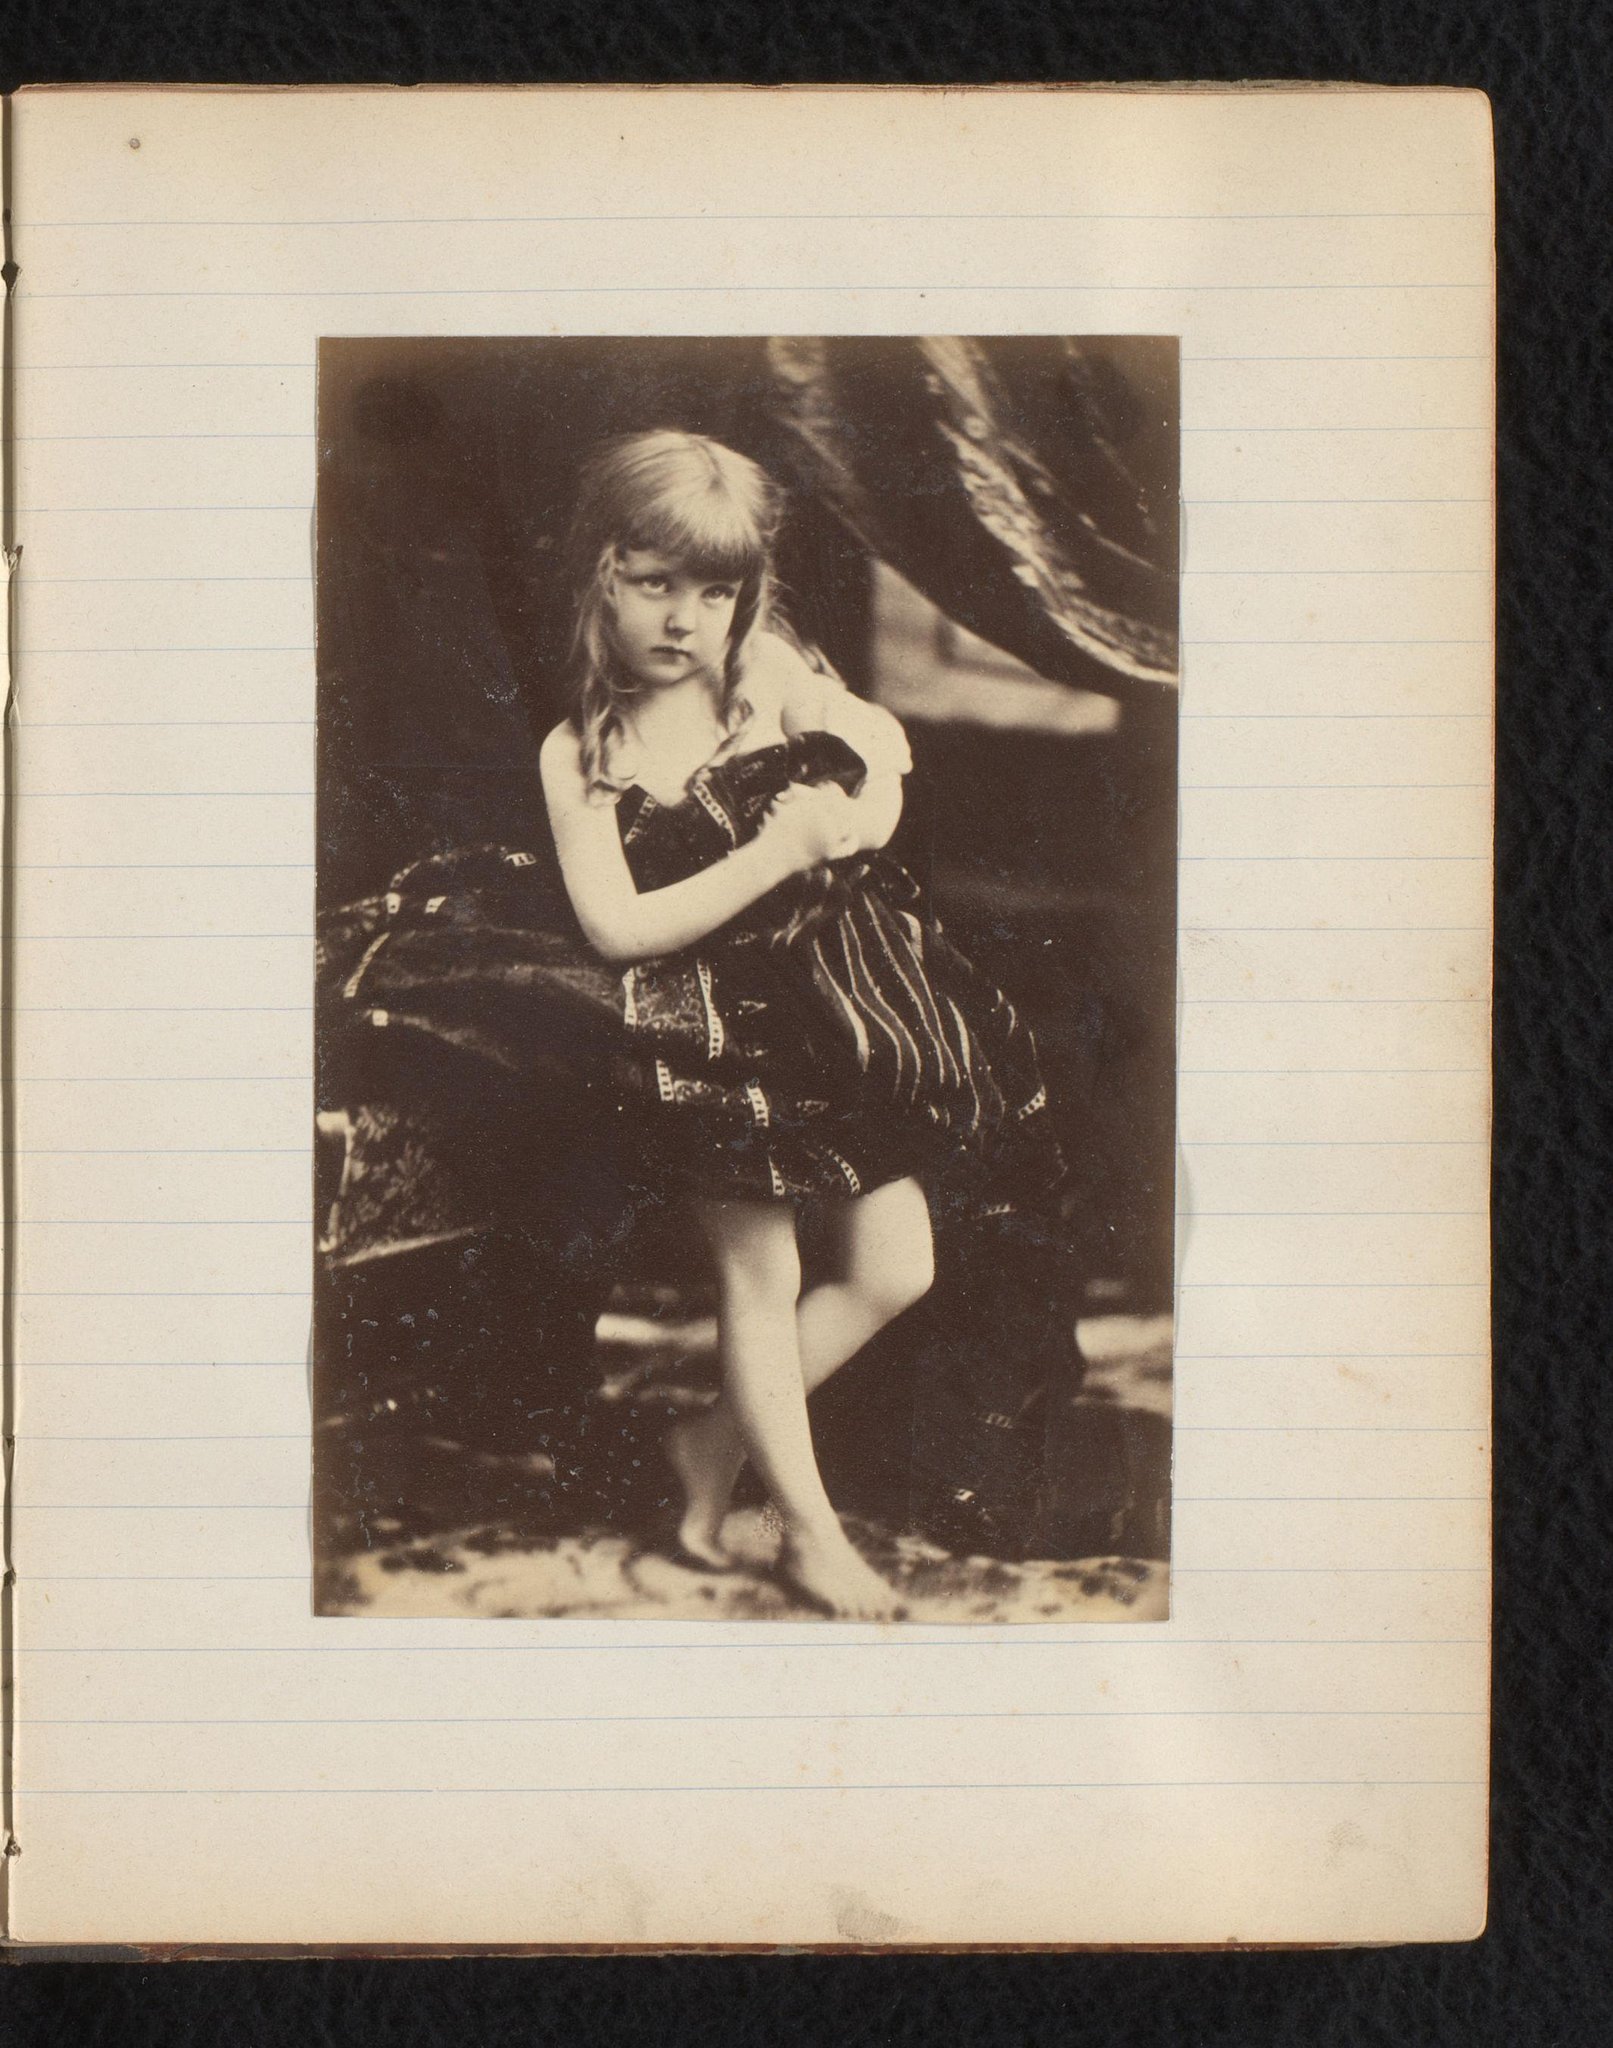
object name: album leaf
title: Studie van een naakt meisje in draperie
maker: Anonymous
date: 1883-1914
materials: photographic support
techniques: albumen print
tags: girl (child between toddler and youth)